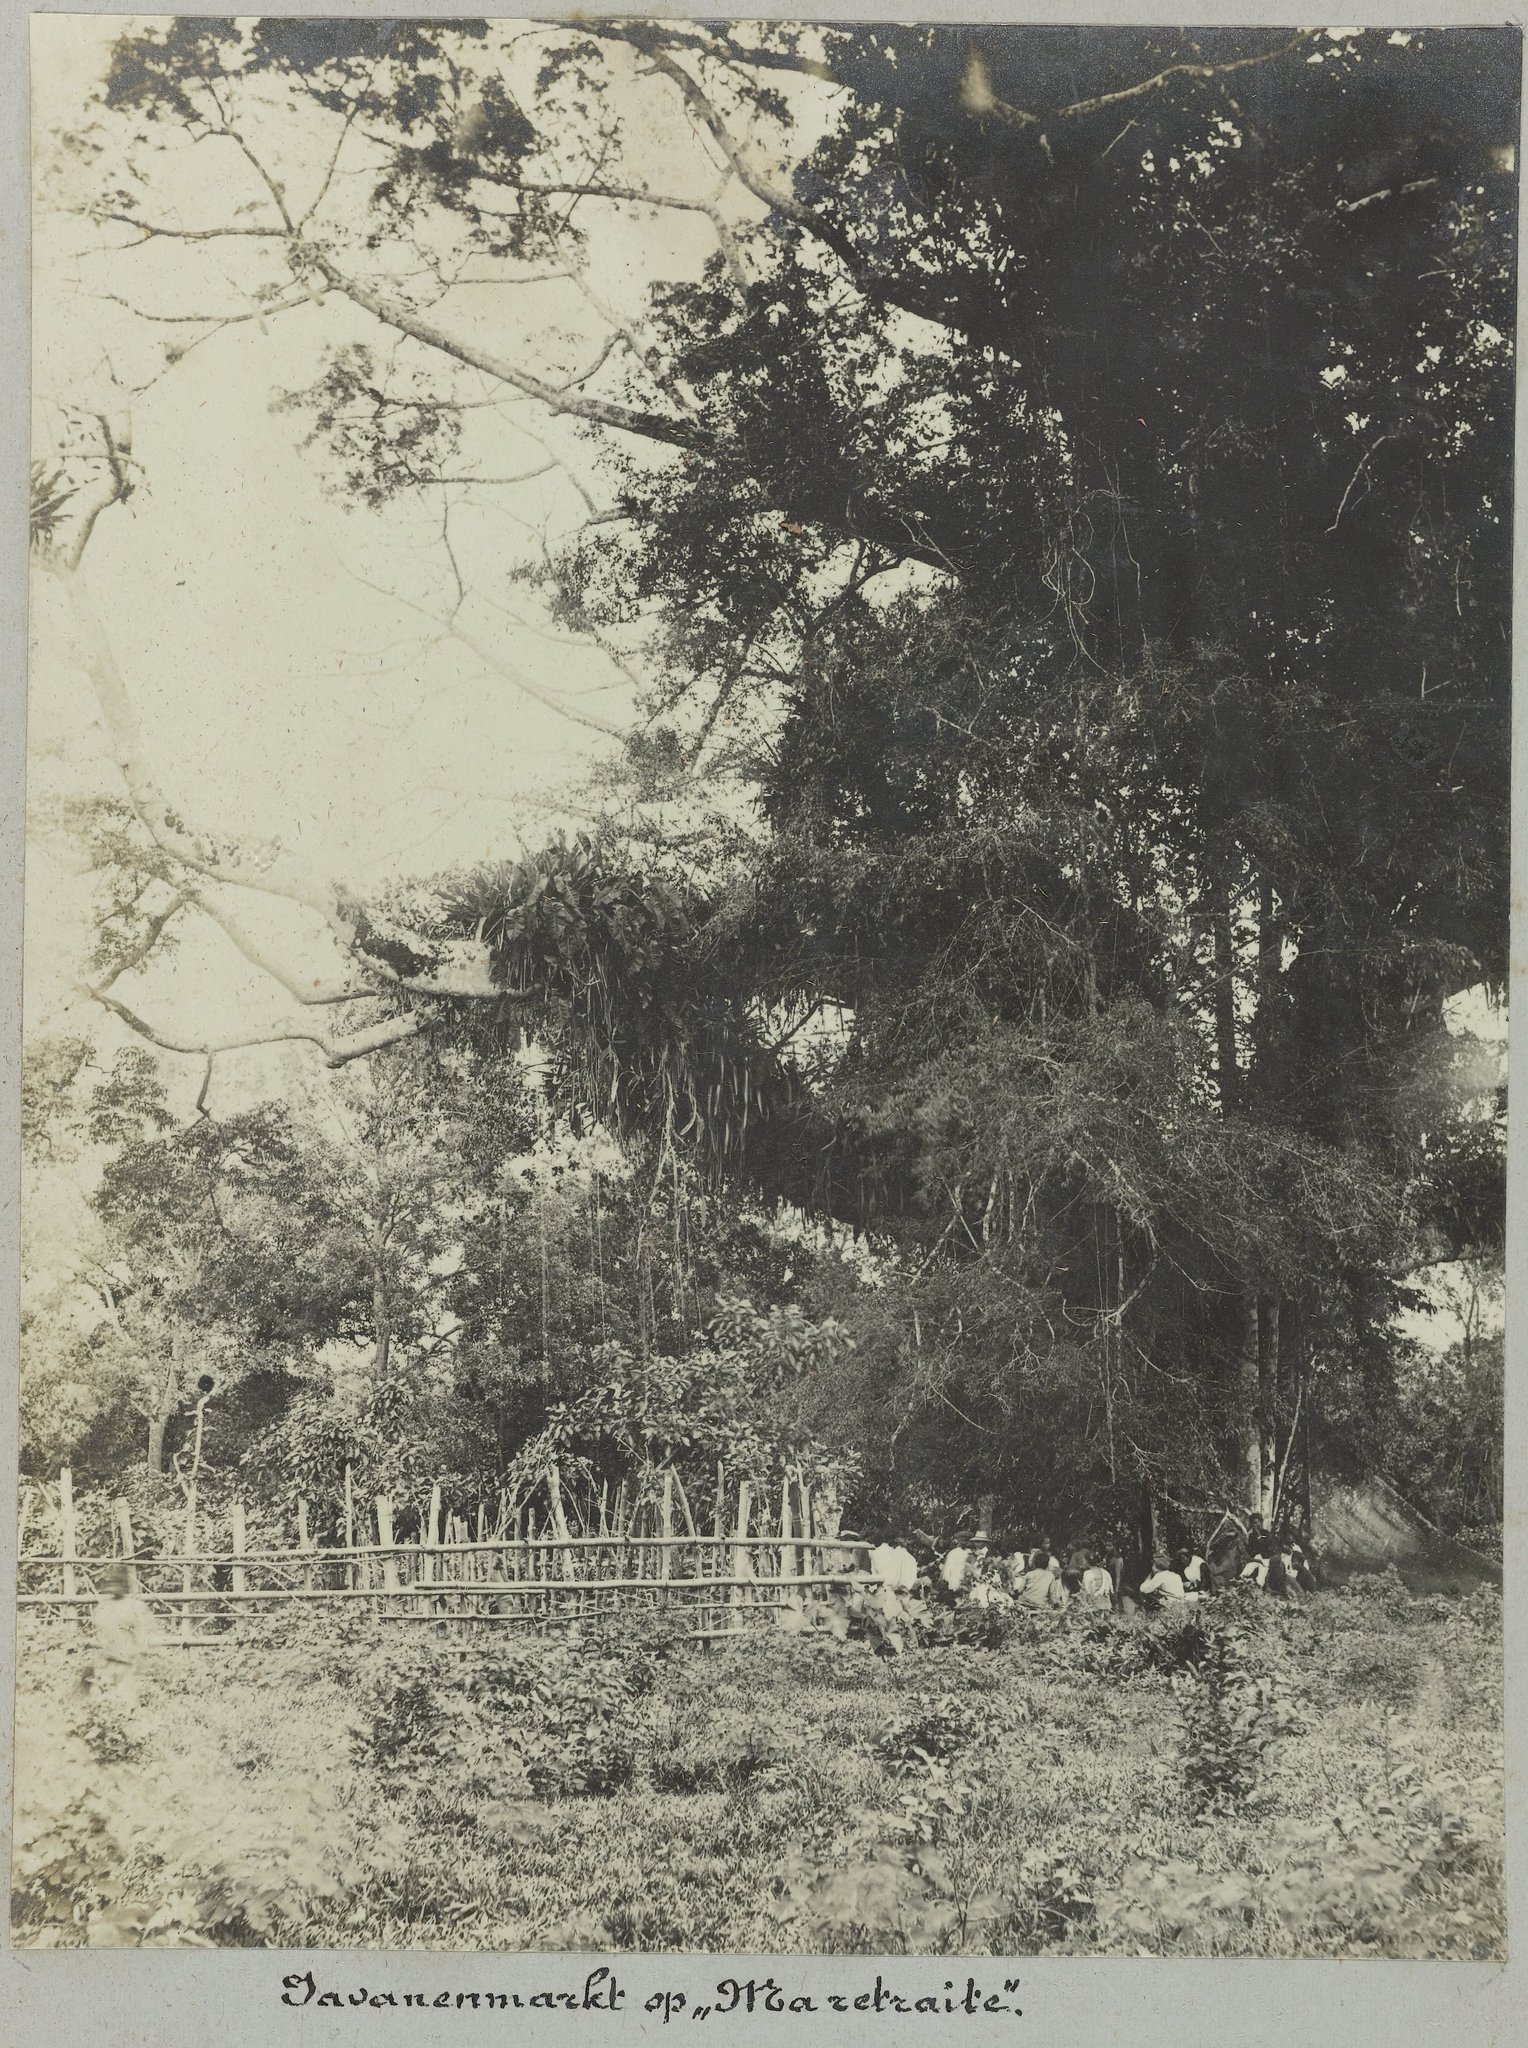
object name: photograph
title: Javanenmarkt op "Ma retraite"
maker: hendrik doijer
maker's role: engineer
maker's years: 1863-1925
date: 1903-1910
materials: photographic support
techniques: gelatin silver print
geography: suriname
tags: suriname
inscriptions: inscription: ‘A16 / Javanenmarkt op "Ma retraite".’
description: Kleine markt van Javanen in de openlucht onder een grote boom op het terrein van de plantage Ma Retraite. Onderdeel van het fotoalbum Souvenir de Voyage (deel 1), over het leven van de familie Doijer in en rond de plantage Ma Retraite in Suriname in de jaren 1903-1910.